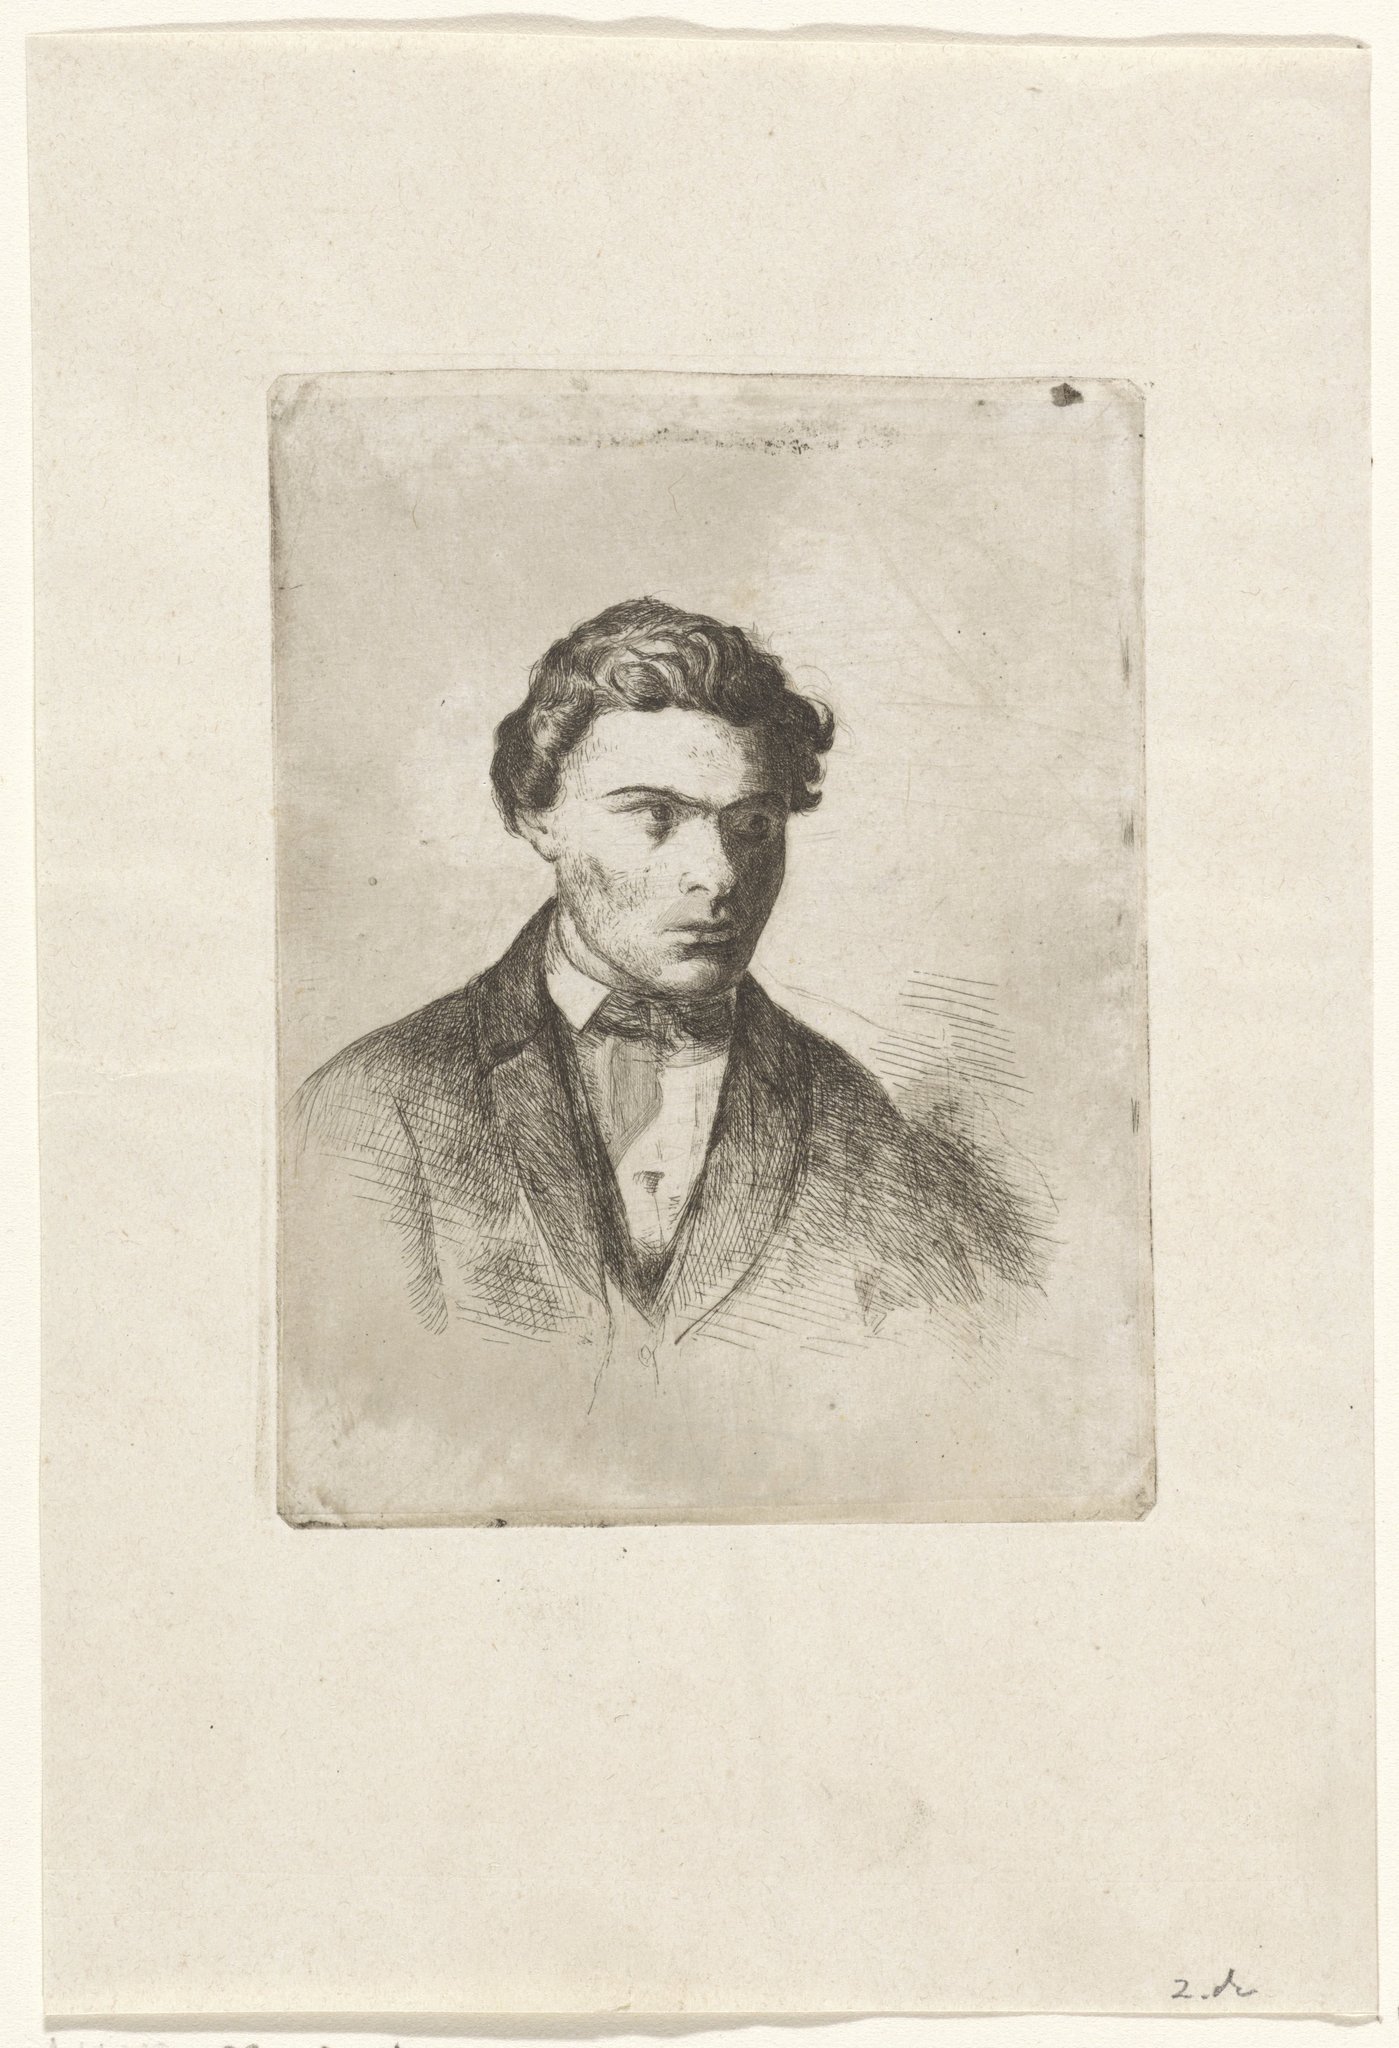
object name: print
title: Zelfportret van Frederik Hendrik Weissenbruch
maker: frederik hendrik weissenbruch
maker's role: draughtsman, print maker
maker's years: 1828-1887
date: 1843-1887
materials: paper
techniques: etching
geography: the hague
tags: the hague, print maker, draughtsman, frederik hendrik weissenbruch, portrait, self-portrait of artist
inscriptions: collector's mark: Lugt 2228